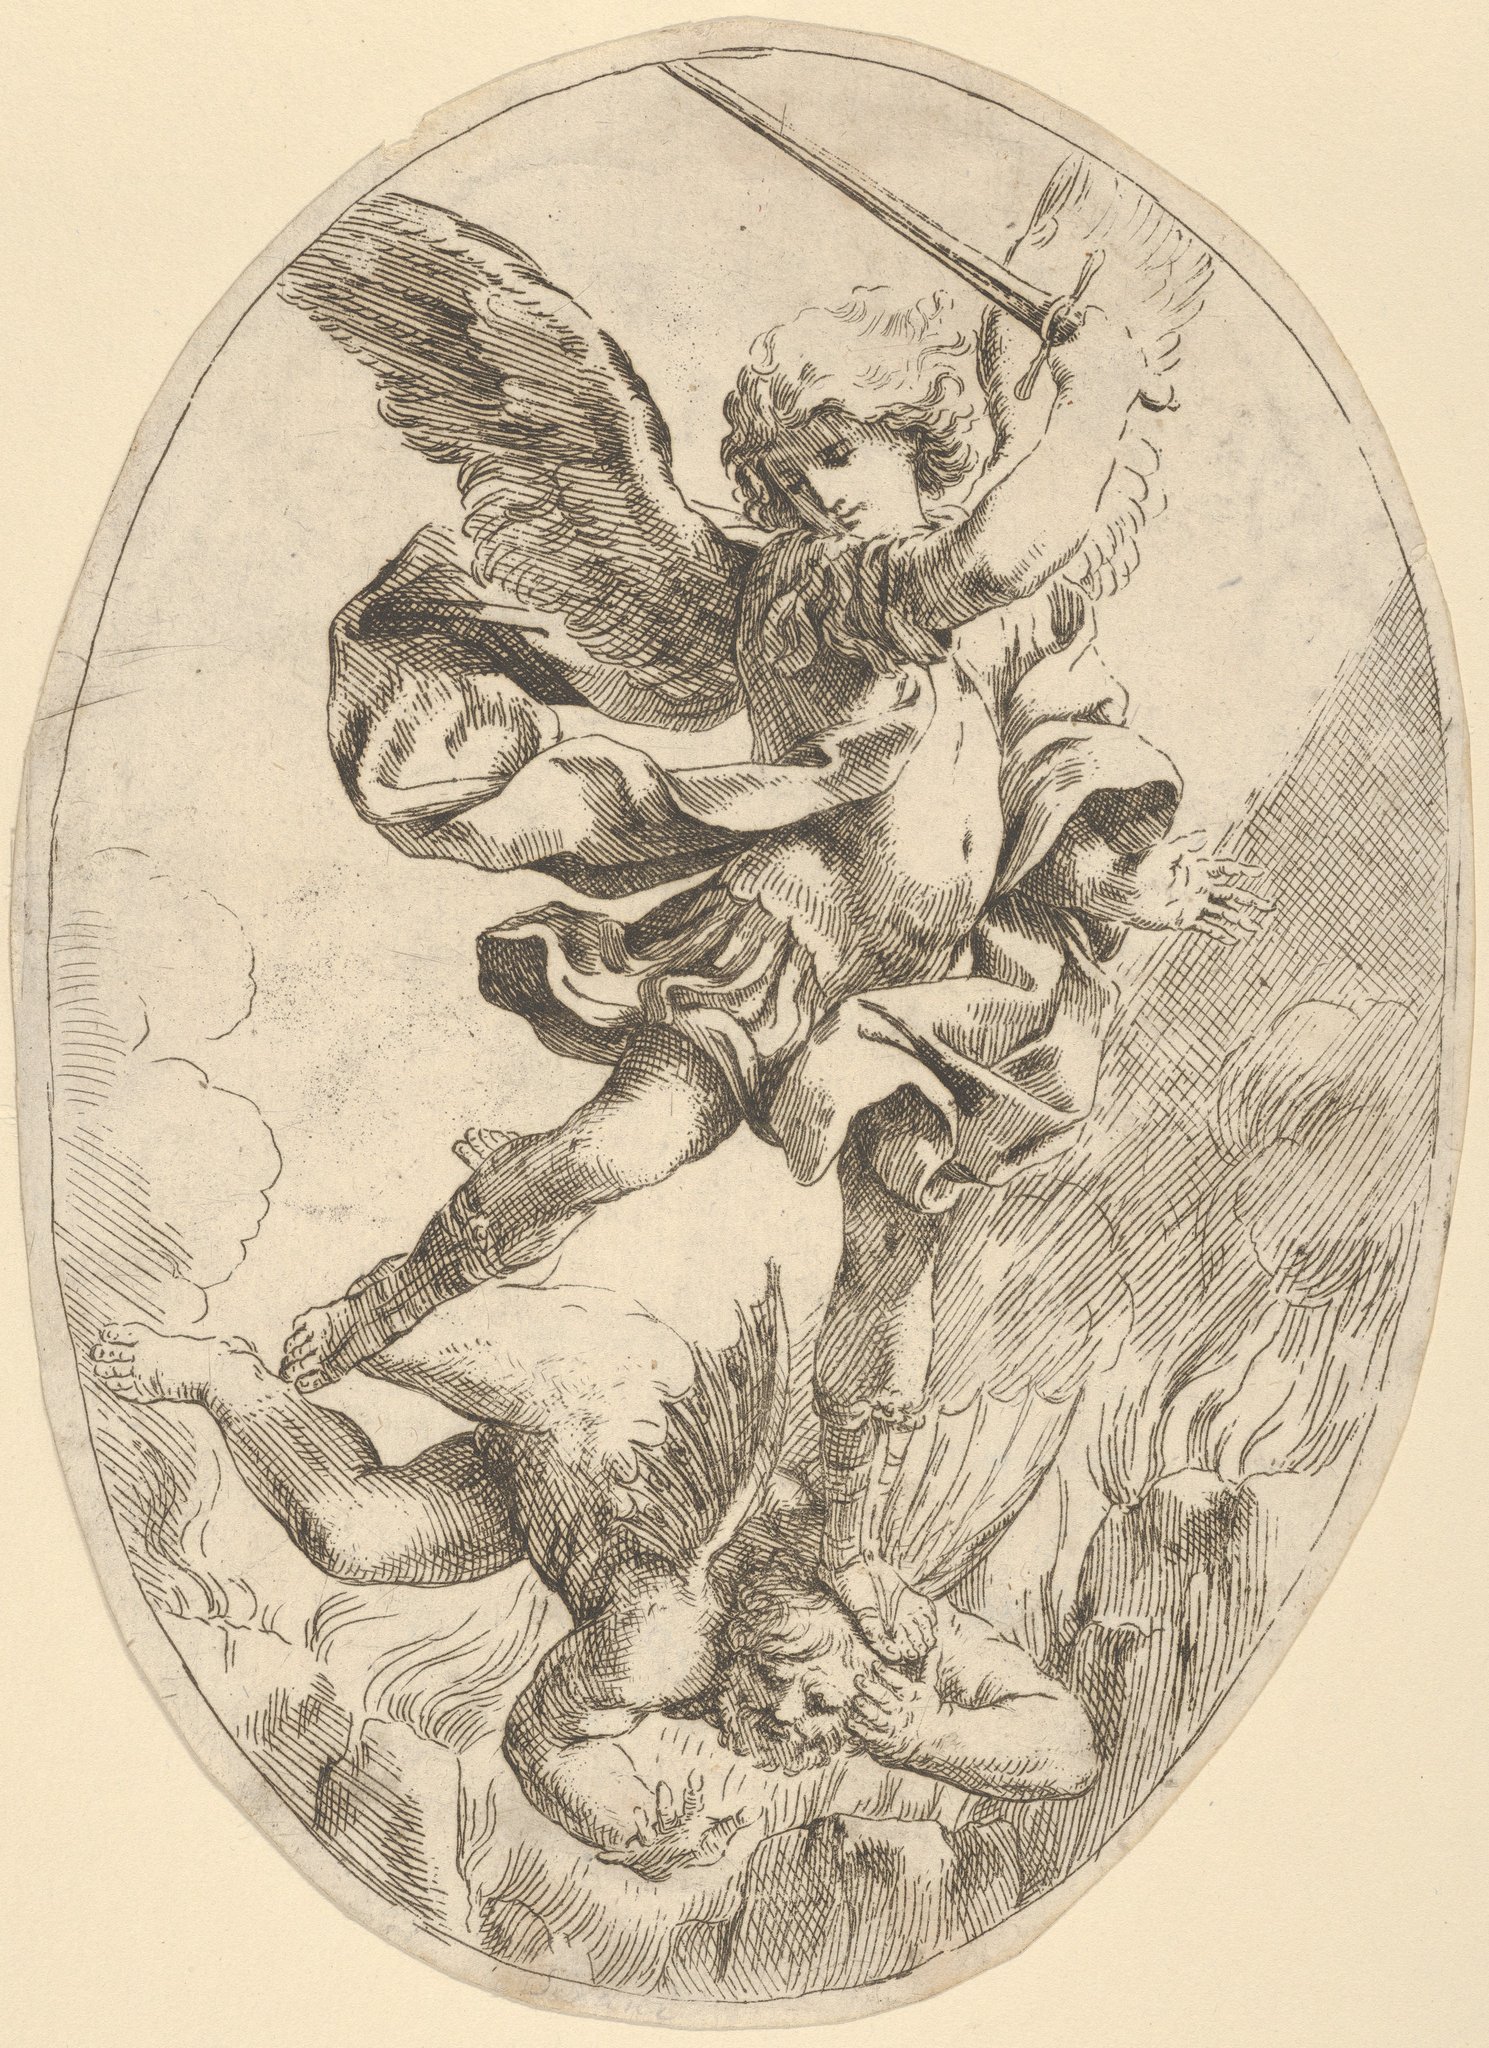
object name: print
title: The winged archangel Saint Michael holding a sword and standing on the head of the devil, who descends into hell, an oval composition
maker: anonymous, 17th century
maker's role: artist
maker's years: 1600-1700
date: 1600-1640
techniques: etching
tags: swords,saint michael,devil